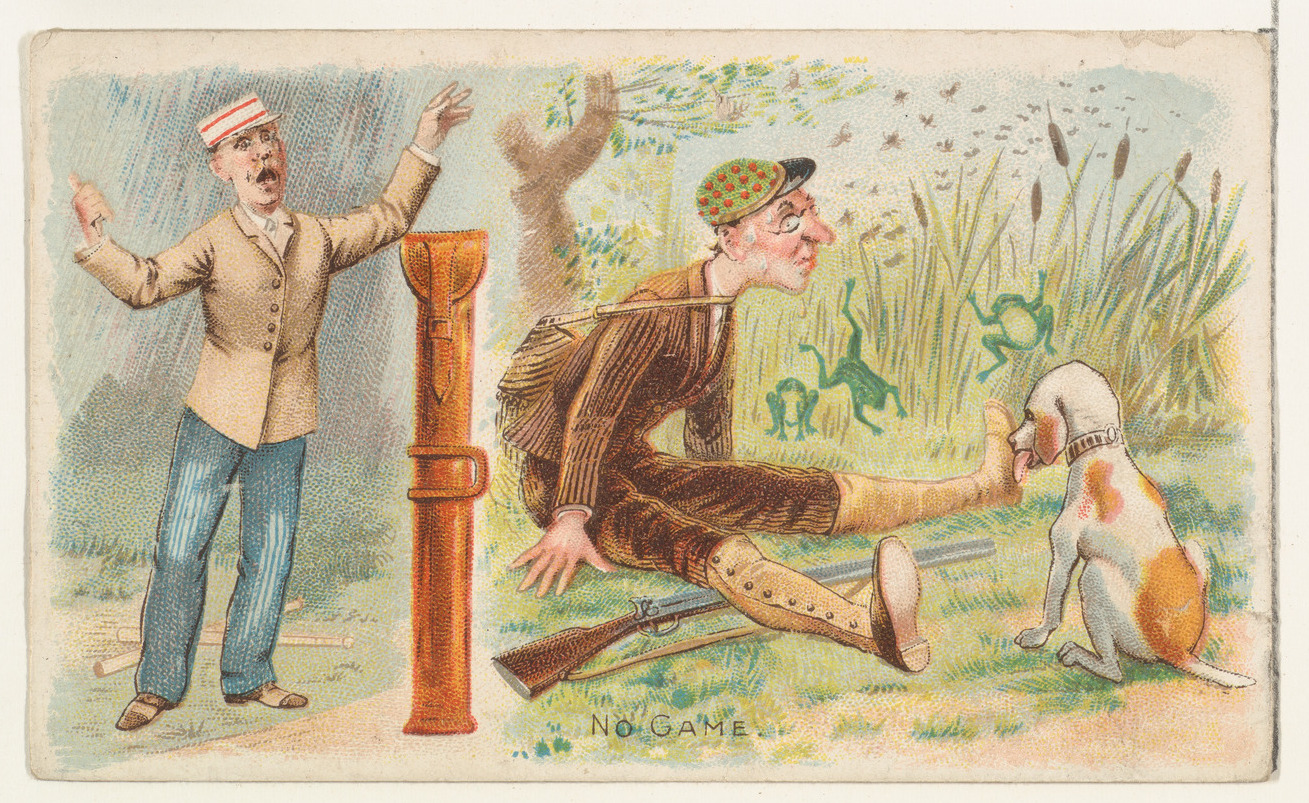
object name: print, baseball card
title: No Game, from the Talk of the Diamond set (N135) issued by Duke Sons & Co., a branch of the American Tobacco Company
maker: w. duke, sons & co.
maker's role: publisher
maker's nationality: american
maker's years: 1870-1920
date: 1888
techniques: color lithograph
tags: firearms,men,dogs